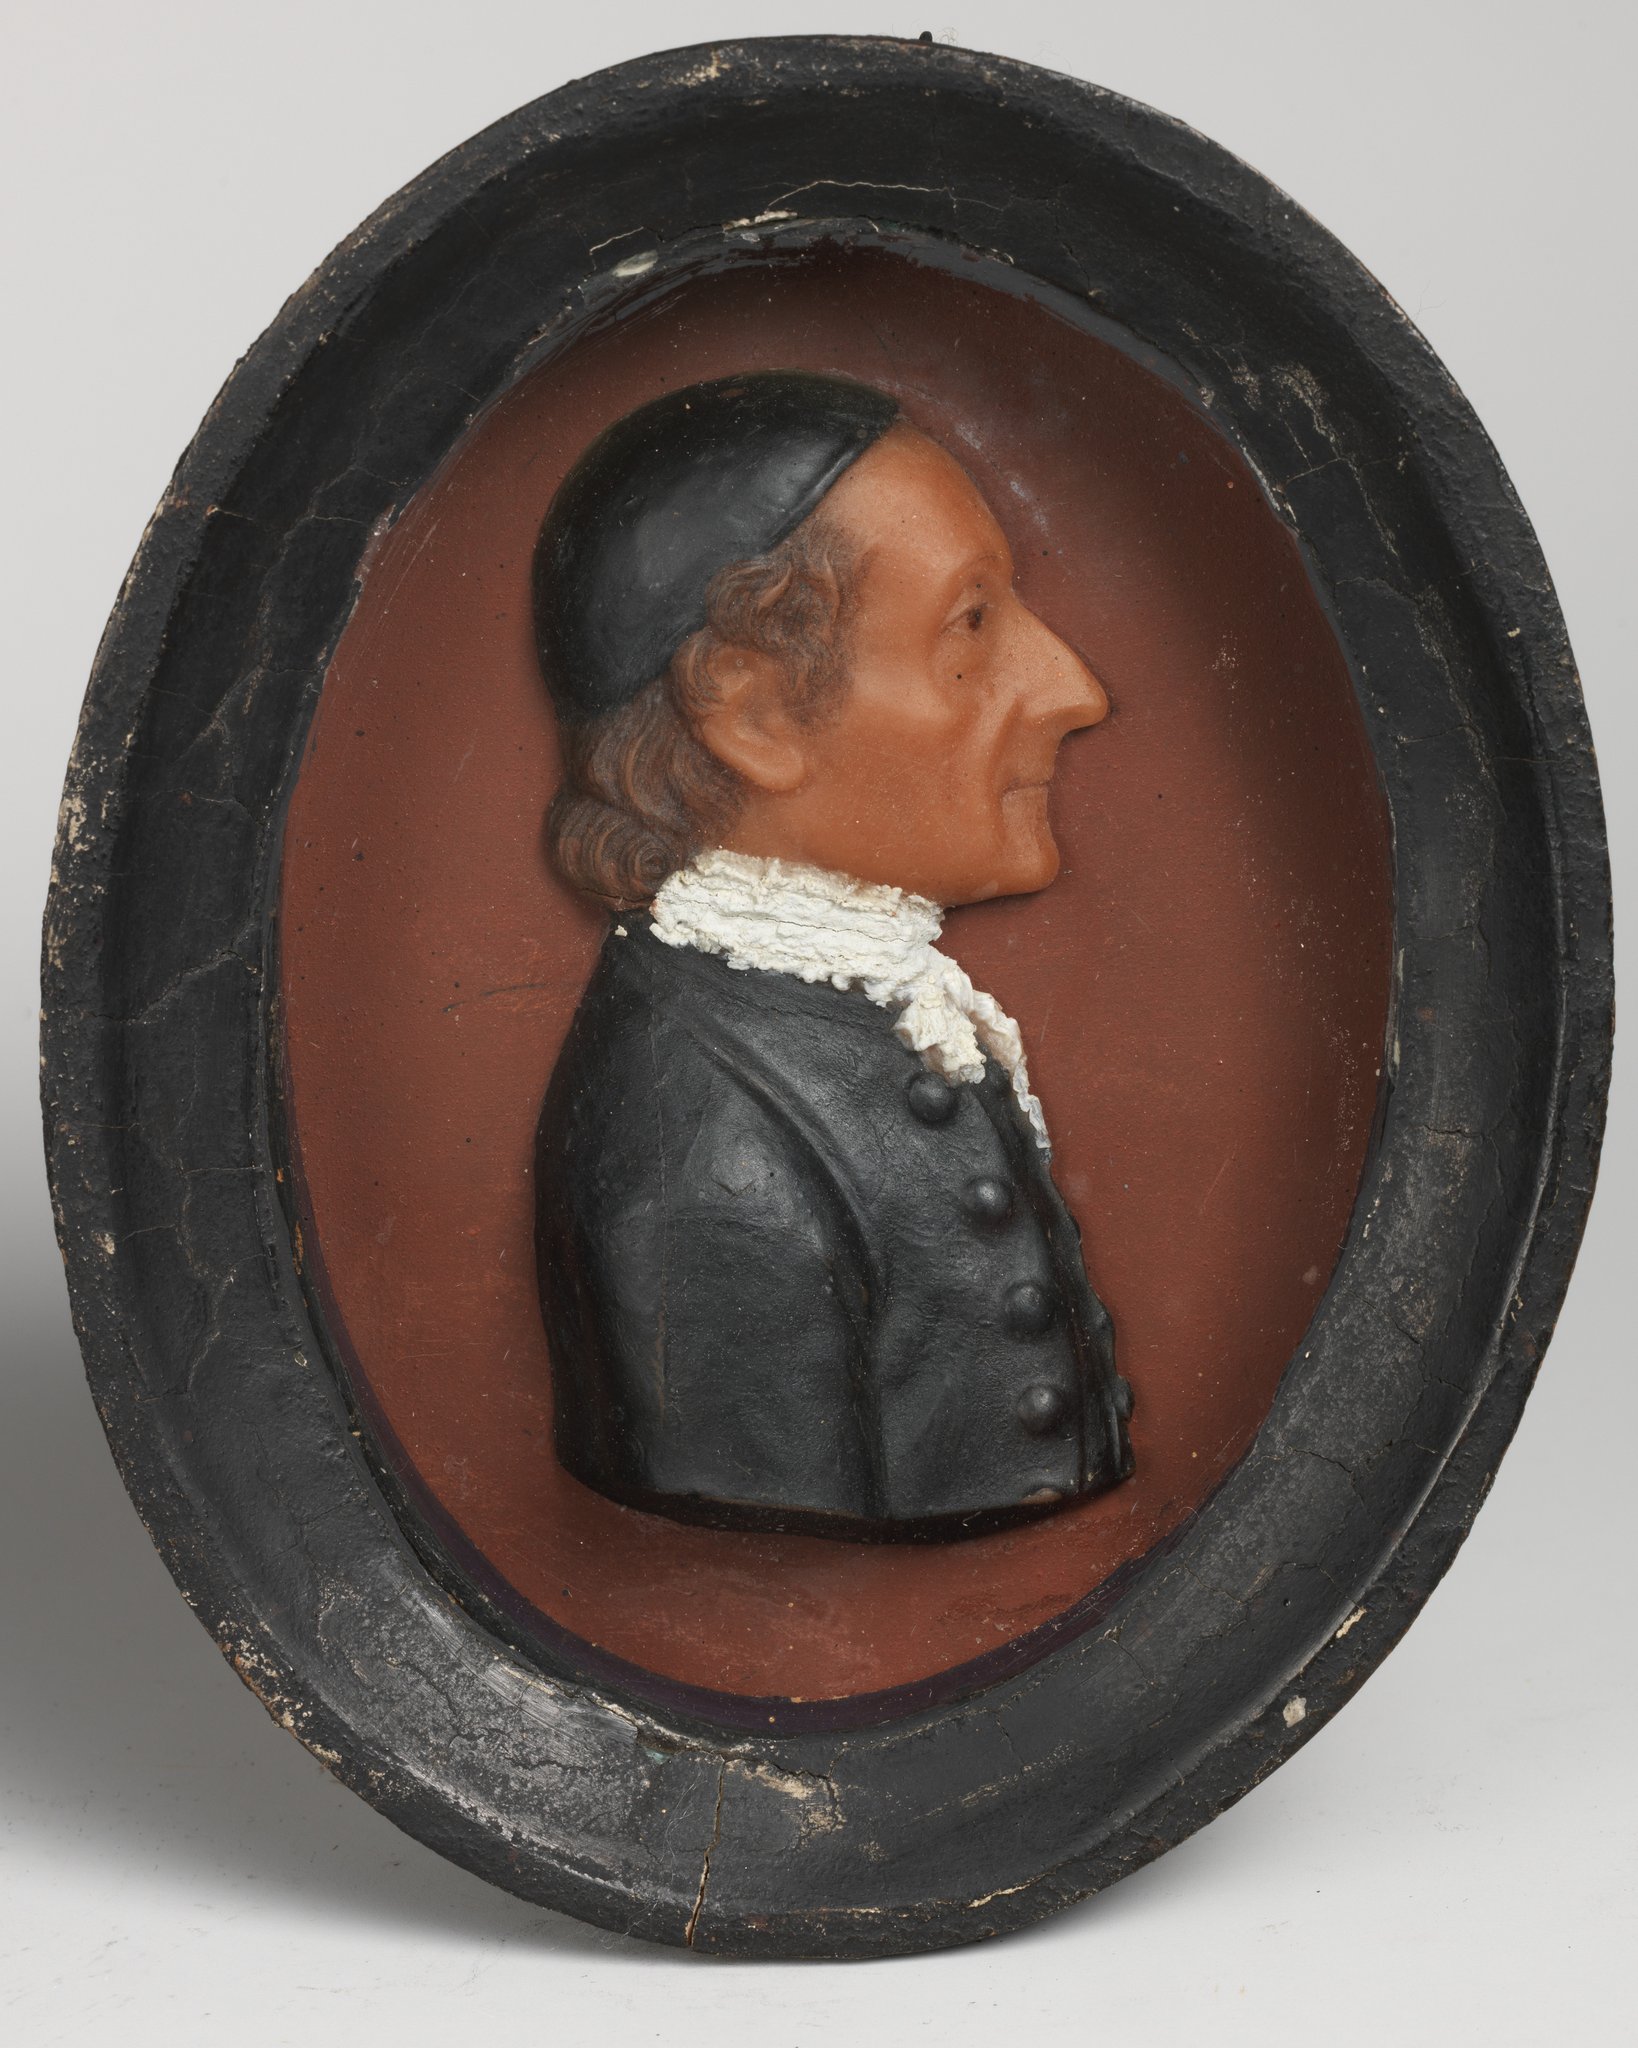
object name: relief bust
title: Portrait of a cleric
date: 1701-1800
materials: wax, wood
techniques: painting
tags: men,profiles